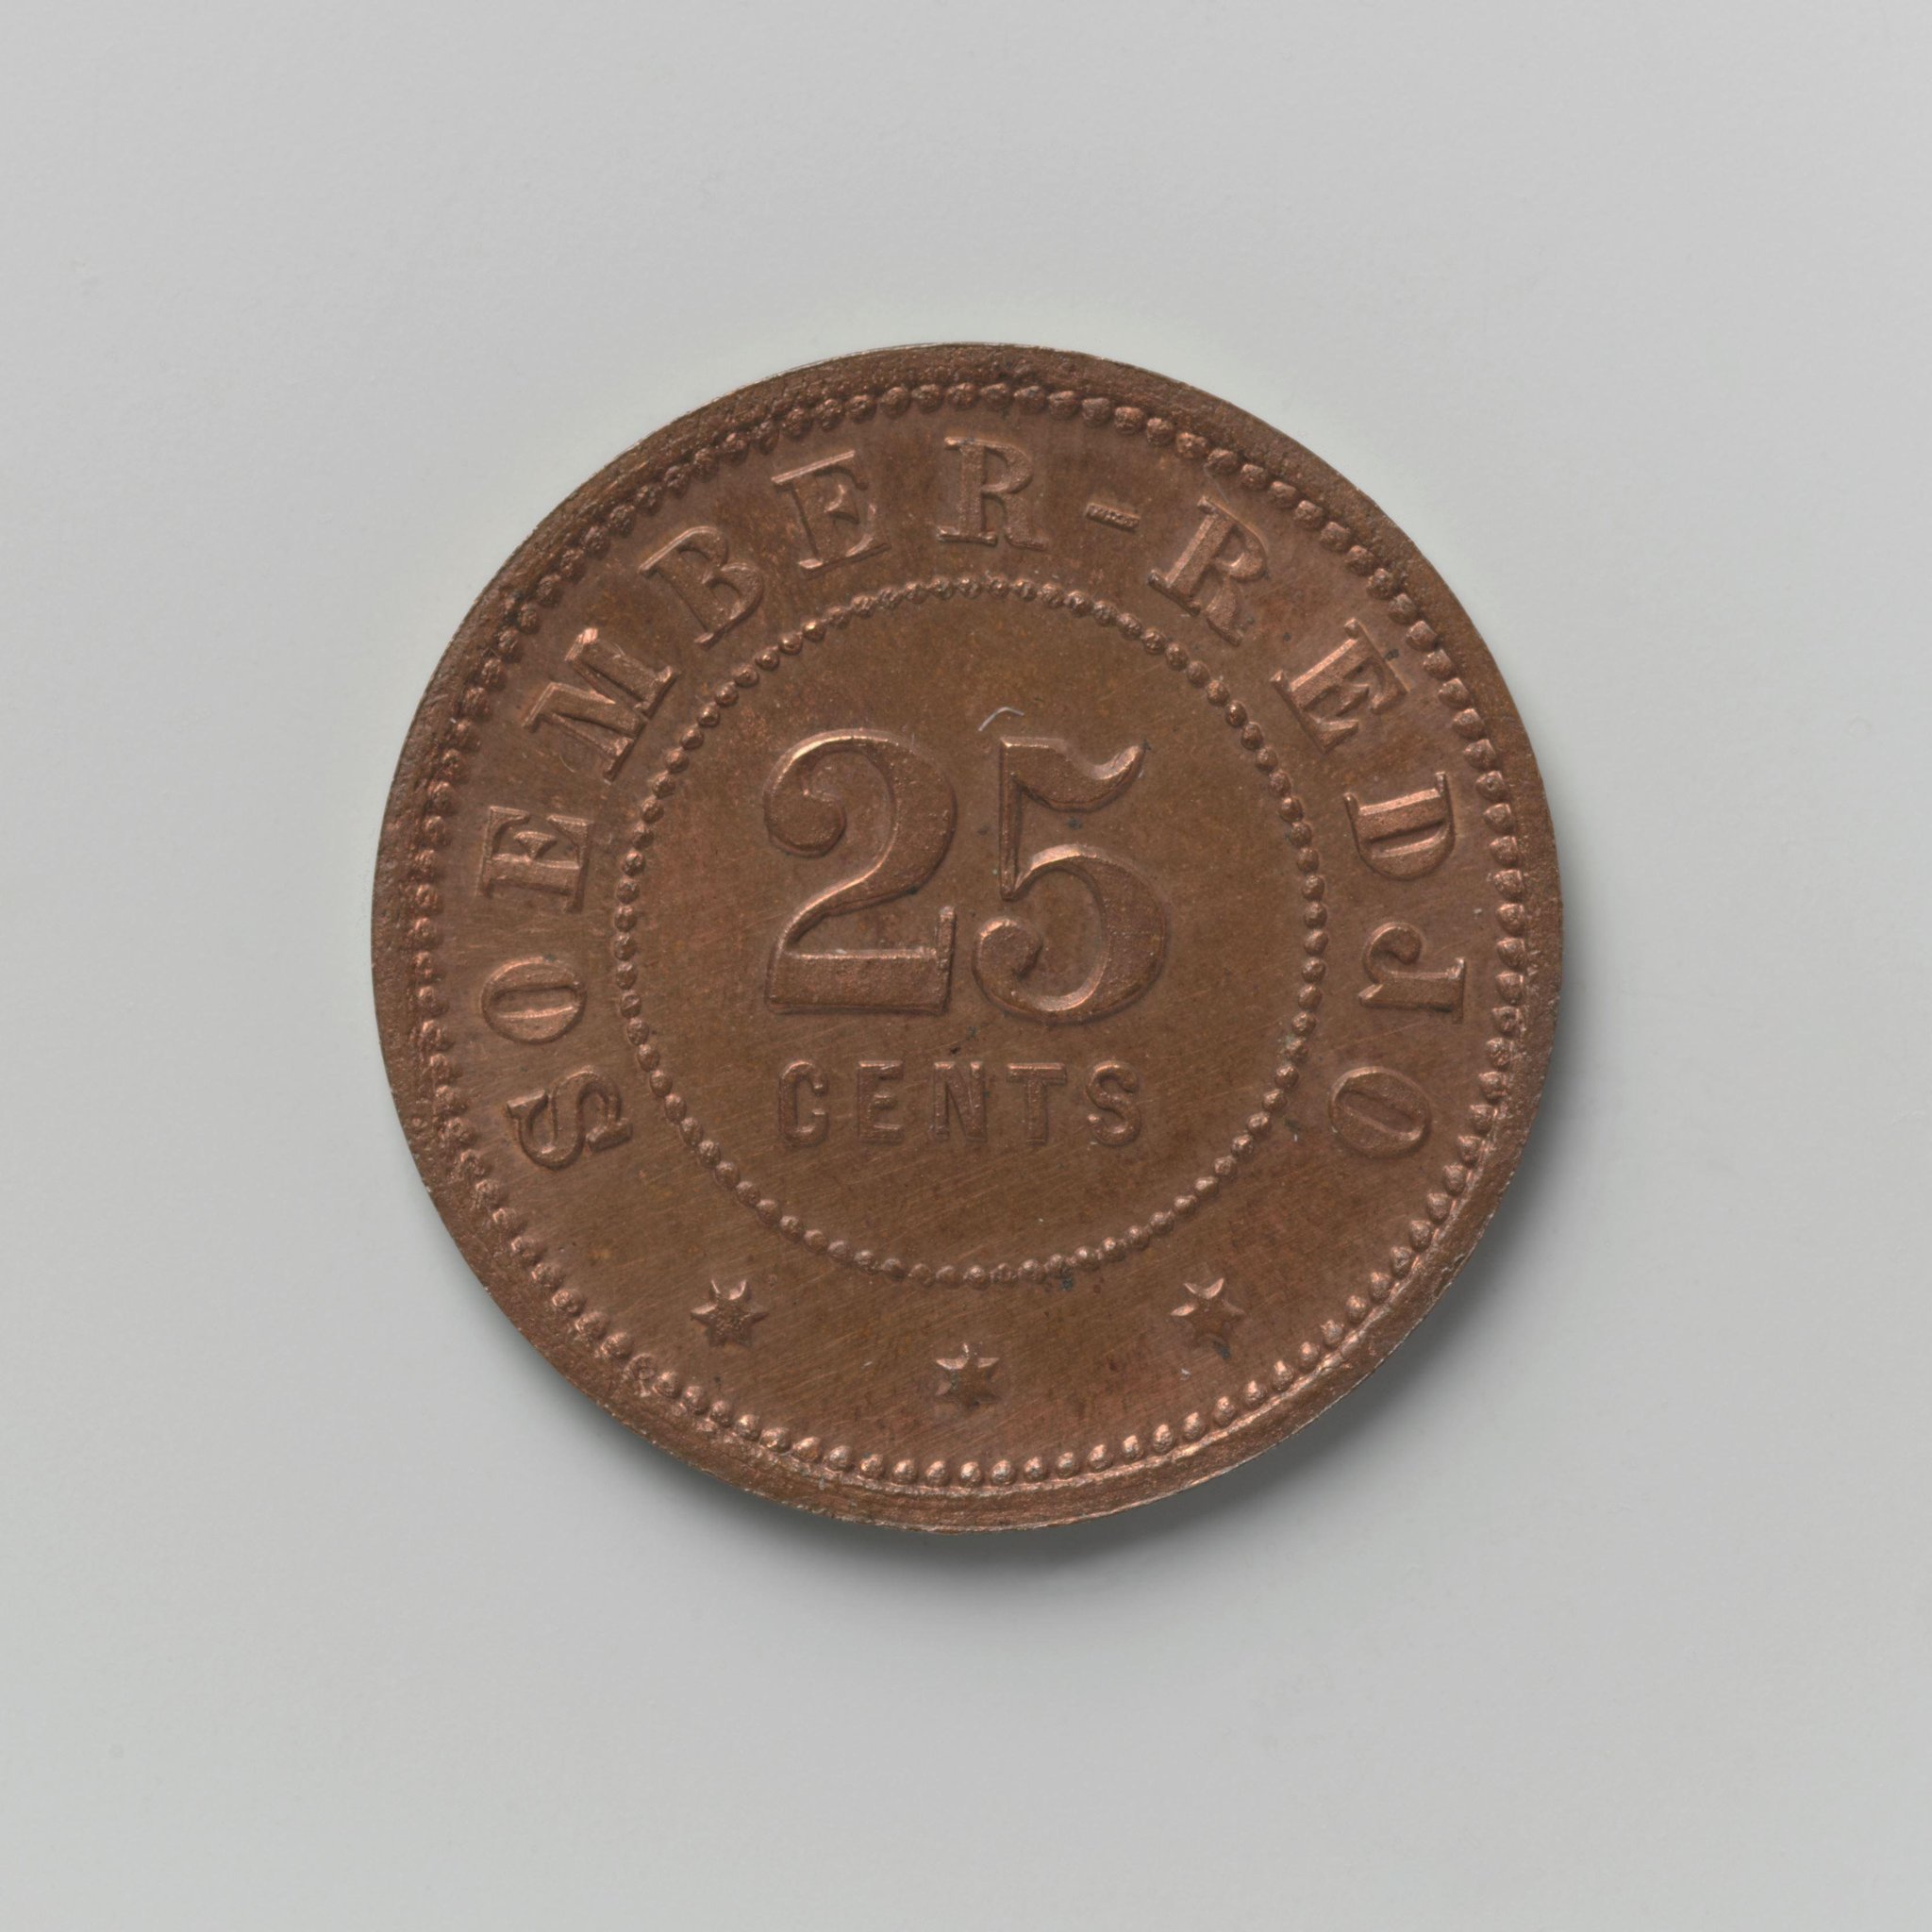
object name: monetary token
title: Vijfentwintig cents voor plantage Soember-Redjo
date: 1875-1925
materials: copper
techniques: striking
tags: plantage soember-redjo, passoeroean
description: Koperen partuculiere munt. Plantage-geld. Voorzijde: in twee regels waarde-aanduiding. In omschrift aanduiding van de plantage. Keerzijde: in twee regels waarde-aanduiding. Gladde rand.